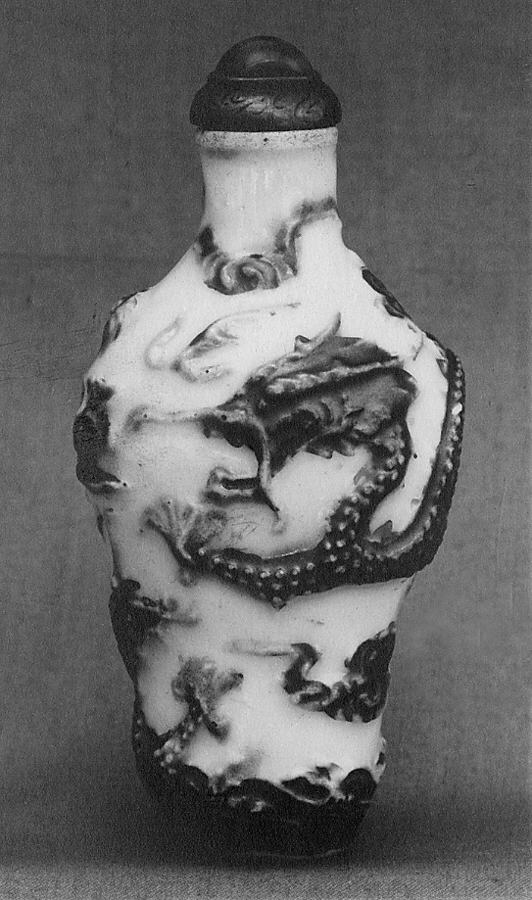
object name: snuff bottle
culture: chinese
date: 1801-1900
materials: gold, porcelain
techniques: molding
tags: dragons